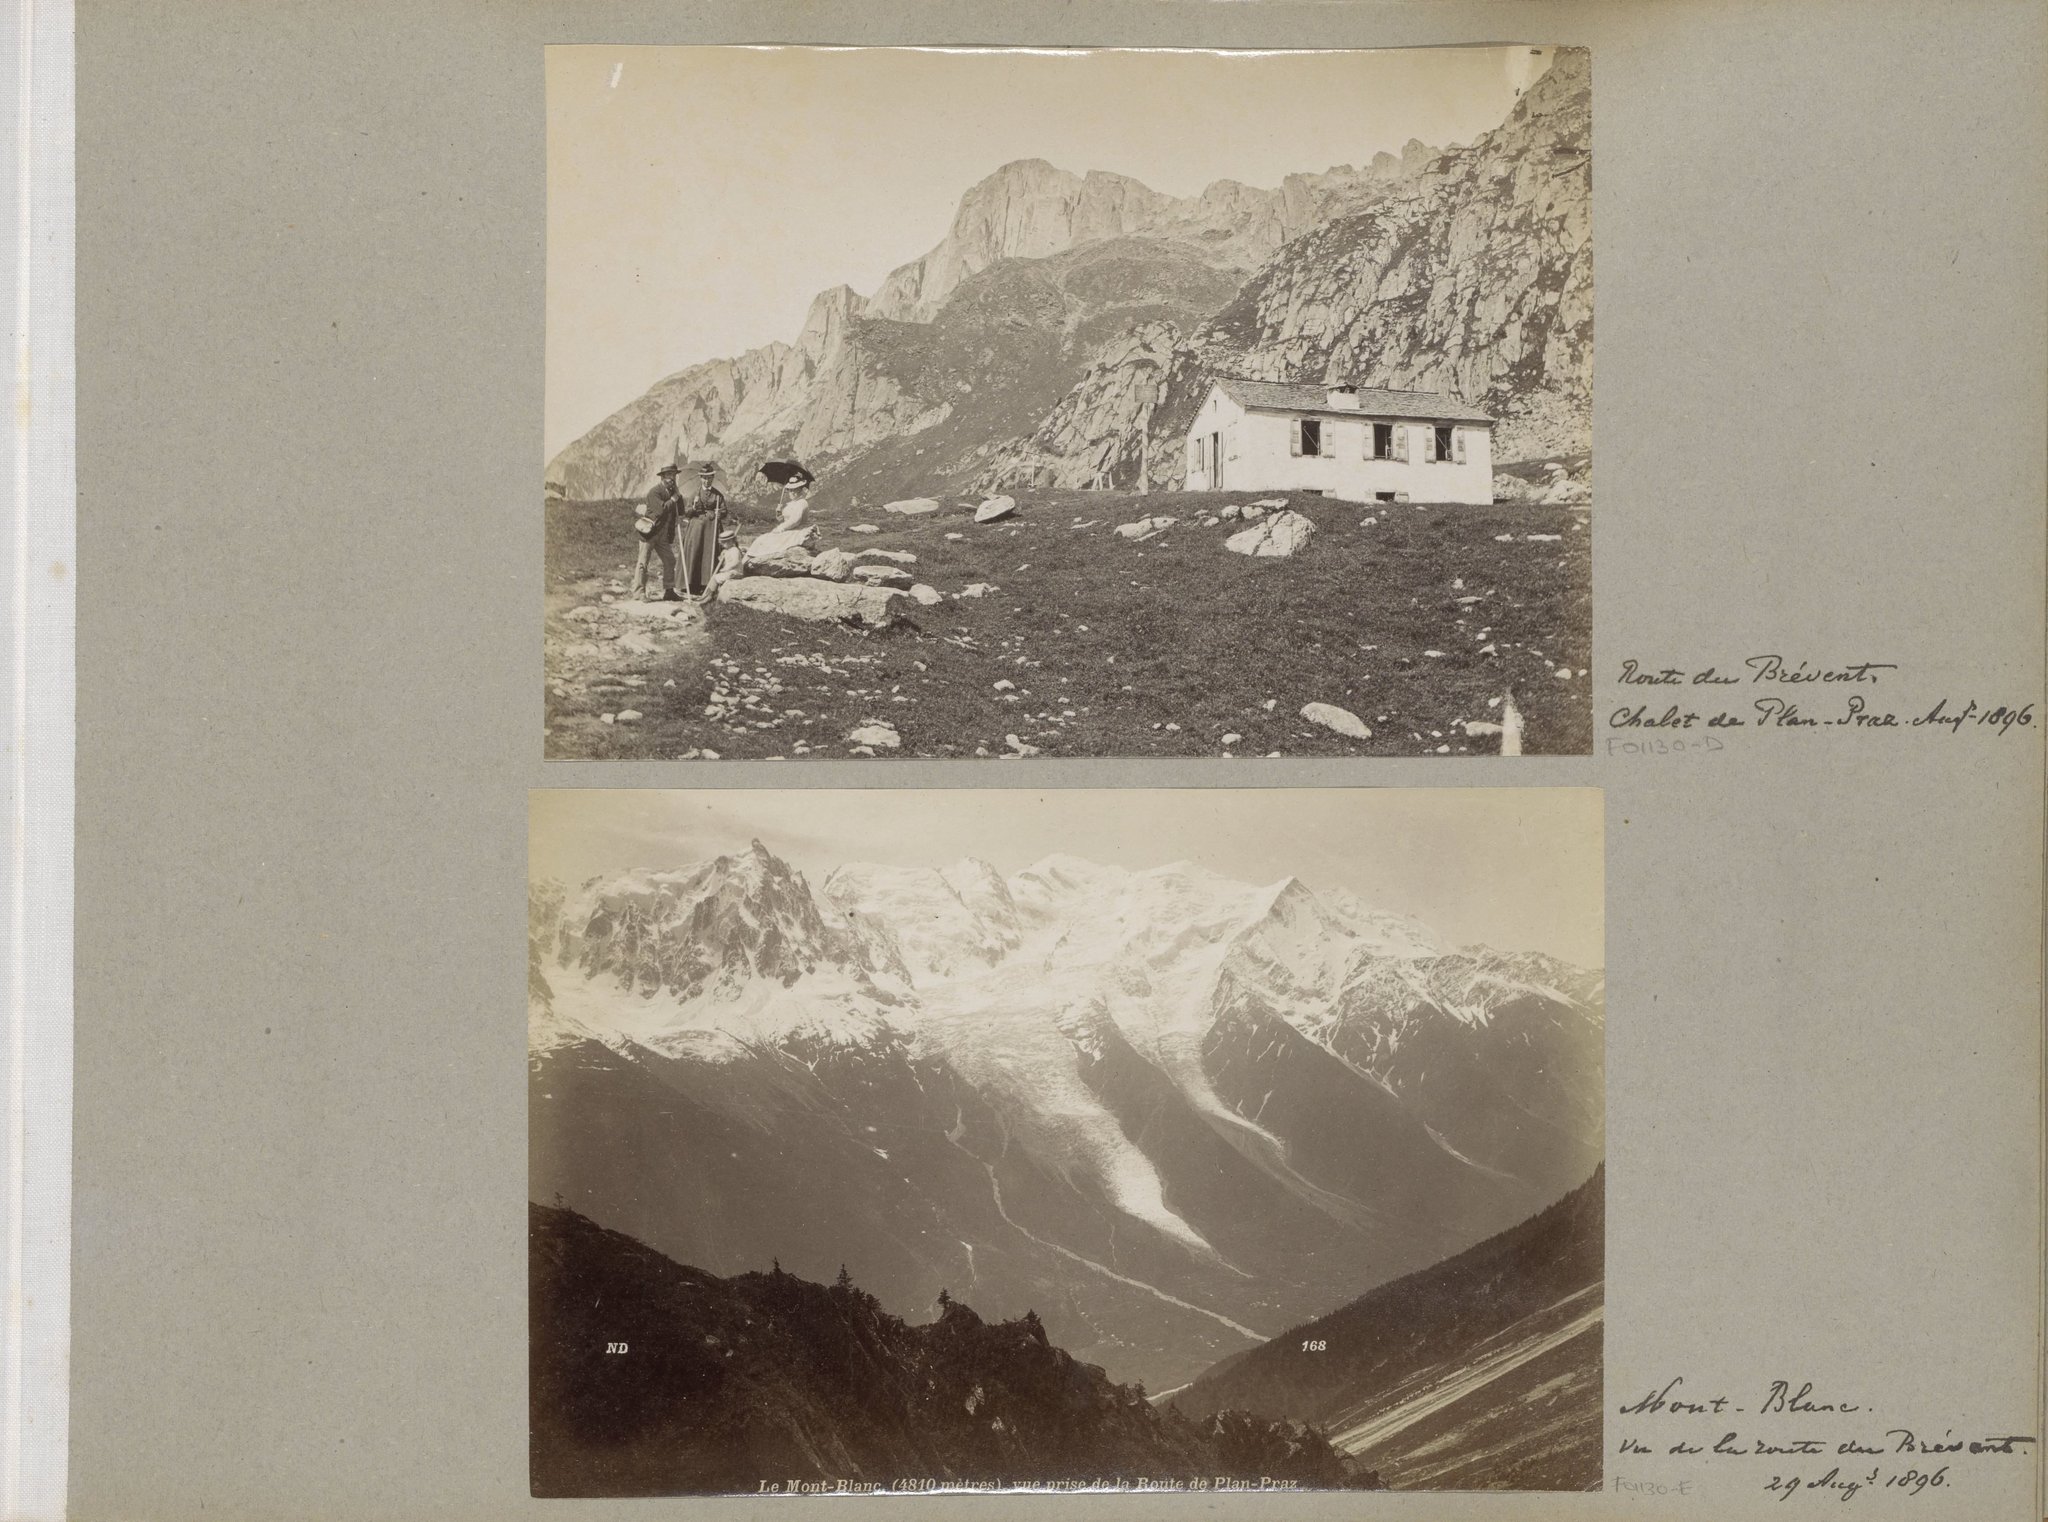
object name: photograph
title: Mont Blanc, gezien vanaf de Route de Plan-Praz op de Brévent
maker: étienne neurdein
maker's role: publisher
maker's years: 1832-1918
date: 1880-1896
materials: paper, photographic support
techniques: albumen print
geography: haute-savoie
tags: mountains (+ landscape with figures, staffage)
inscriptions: negative number: ‘168’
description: Onderdeel van Reisalbum met foto's van bezienswaardigheden in Frankrijk, Spanje, Italië, Duitsland, Zwitserland en Oostenrijk.